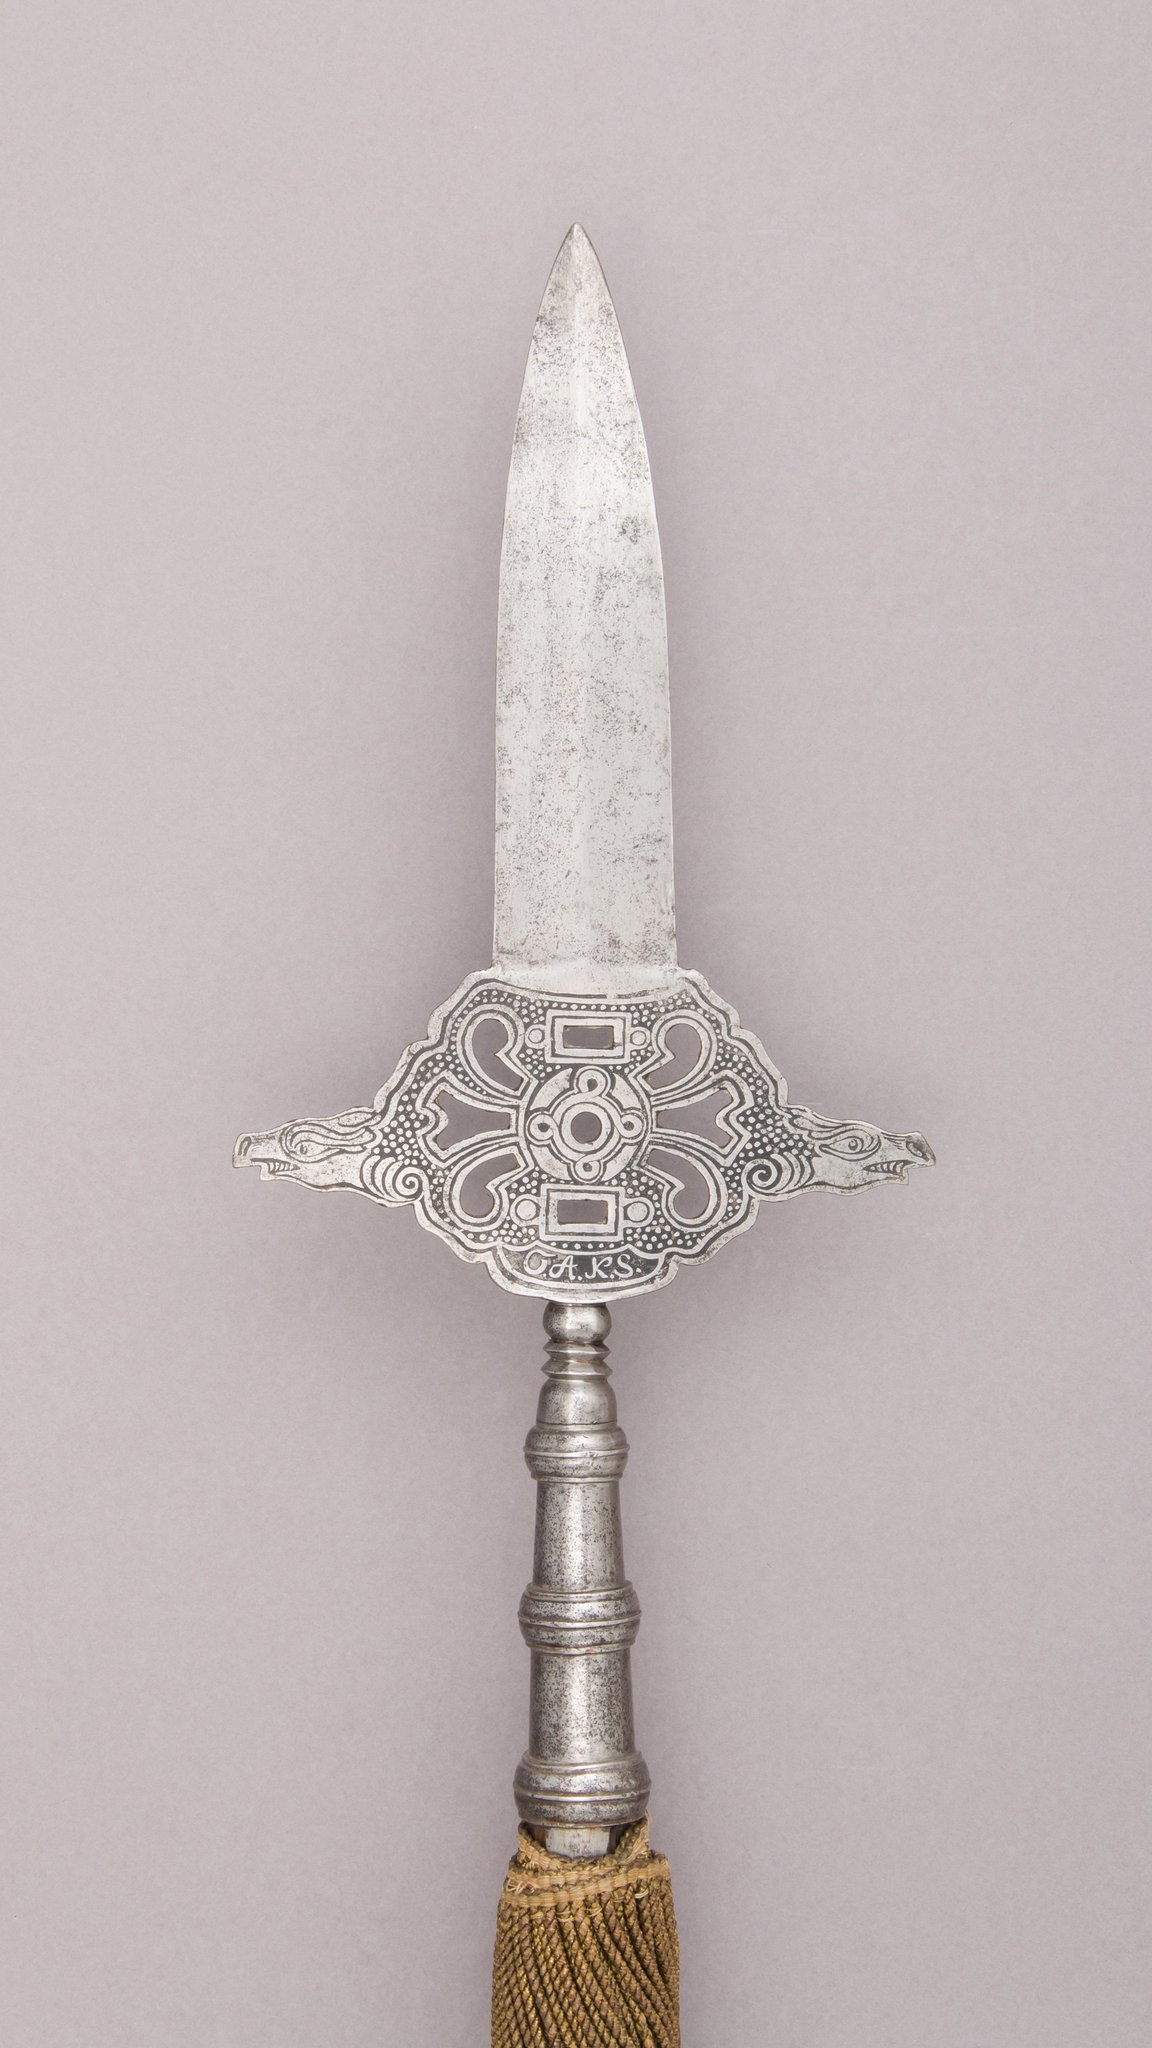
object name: partisan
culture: german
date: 1701-1800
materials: metal thread, steel, textile, wood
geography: germany